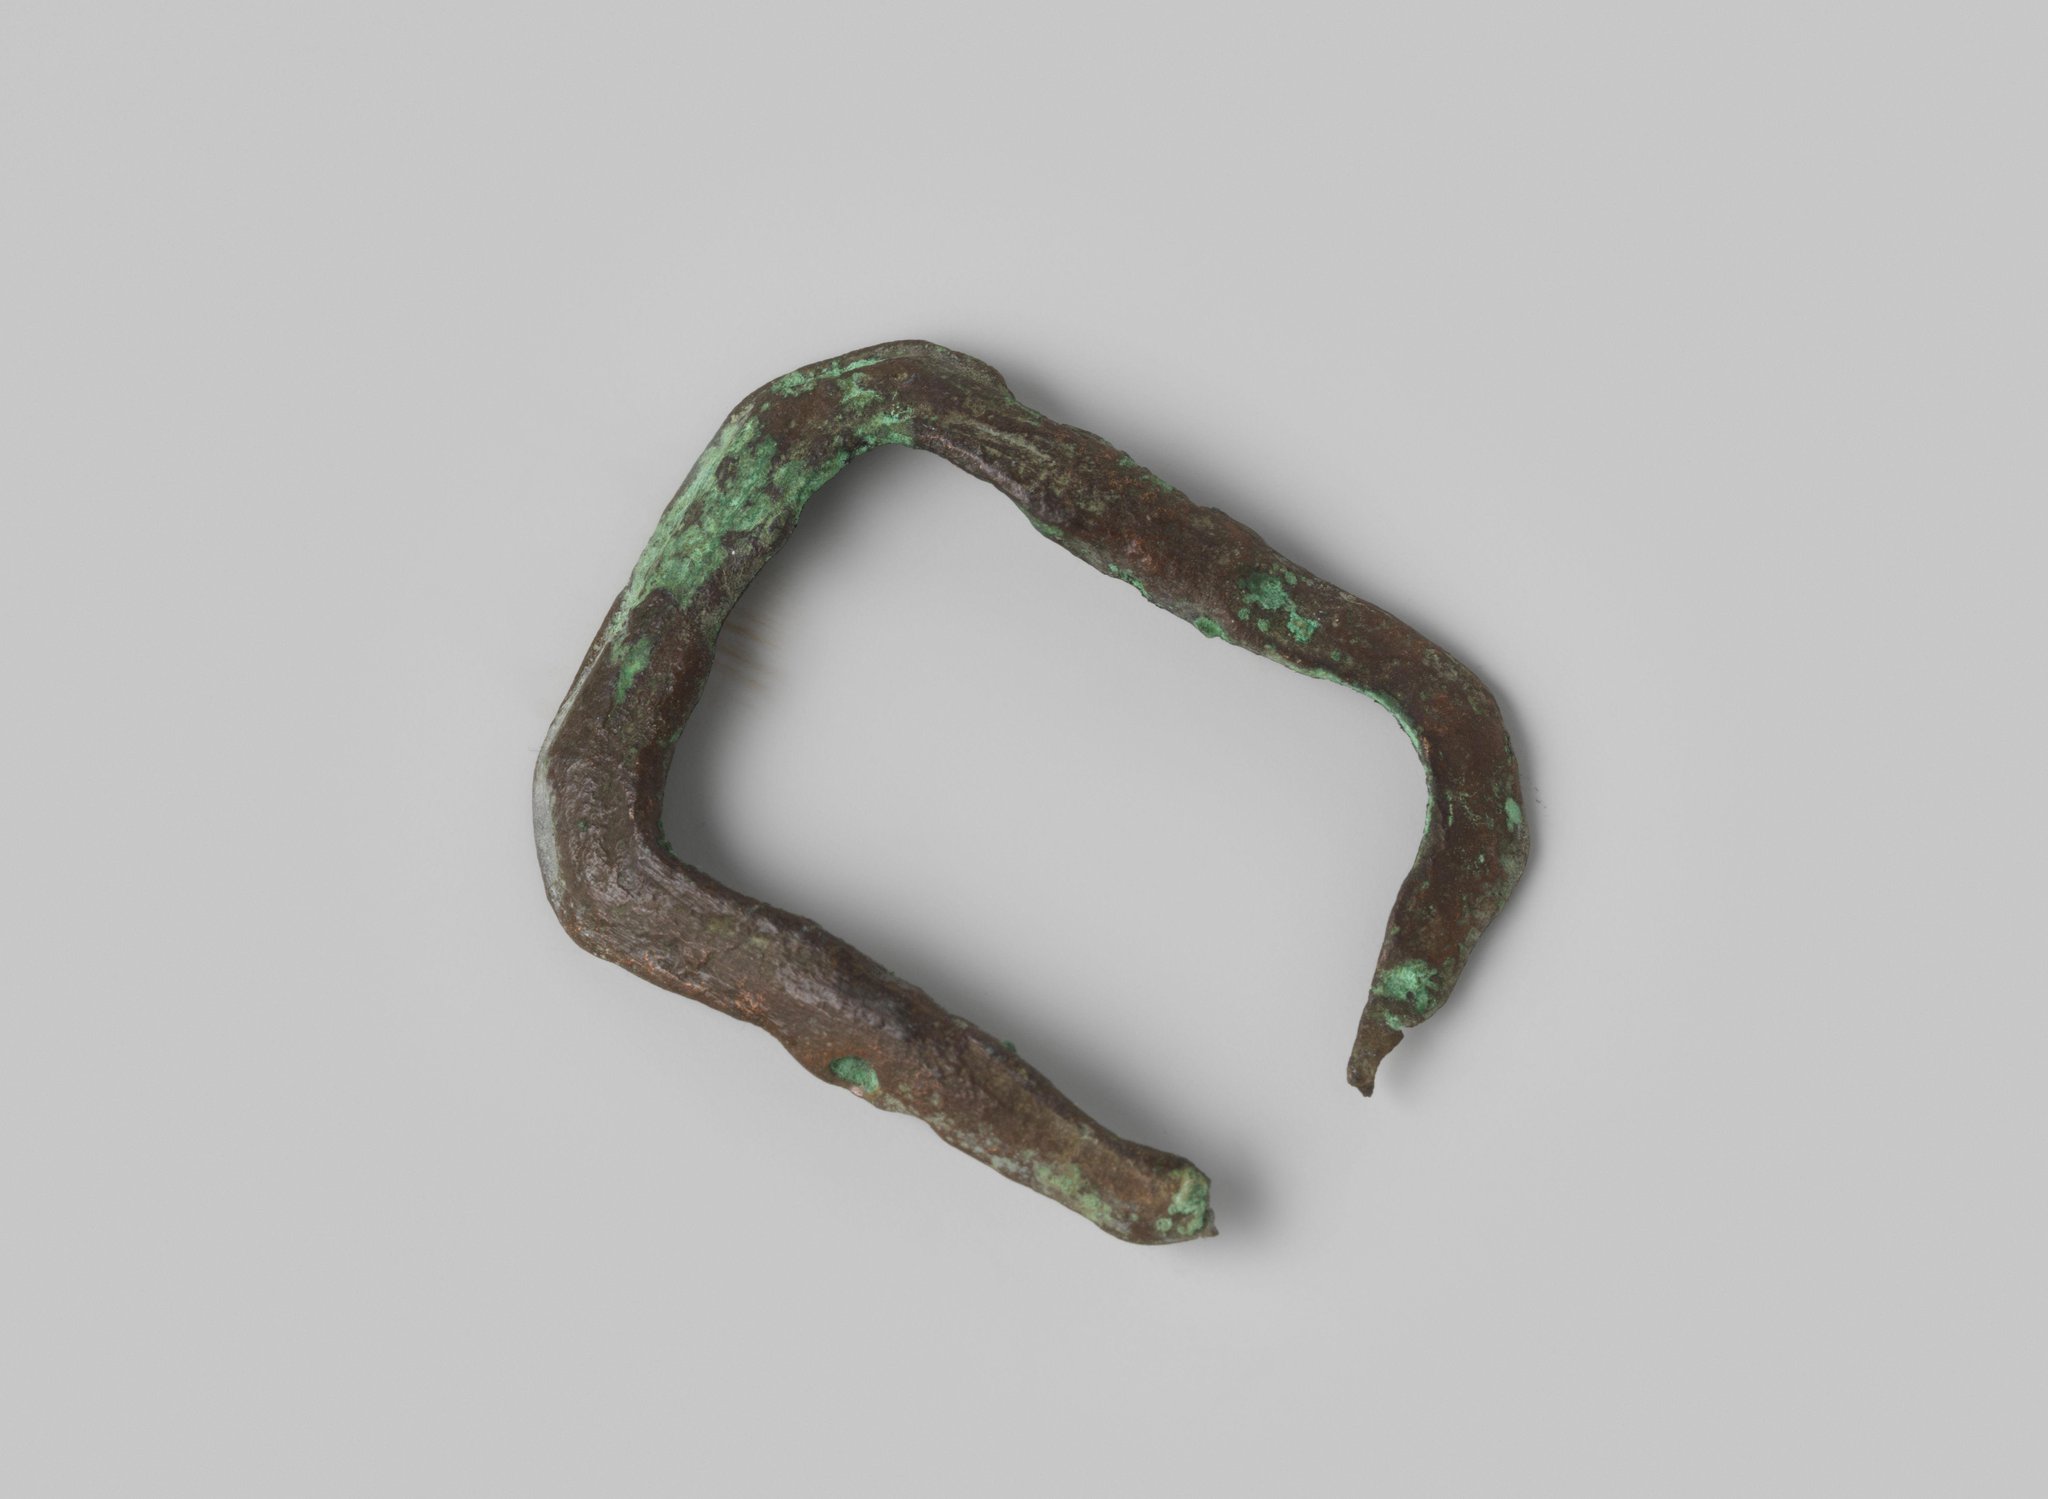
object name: shoe buckle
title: Fragment schoengesp uit het wrak van de Oost-Indiëvaarder Hollandia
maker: Anonymous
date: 1700-1743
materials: copper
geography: netherlands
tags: verenigde oostindische compagnie, hollandia (schip), annet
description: Buckle, chape buckle, shoe buckle; fragment of ring, id. NG 1980-27H1038.